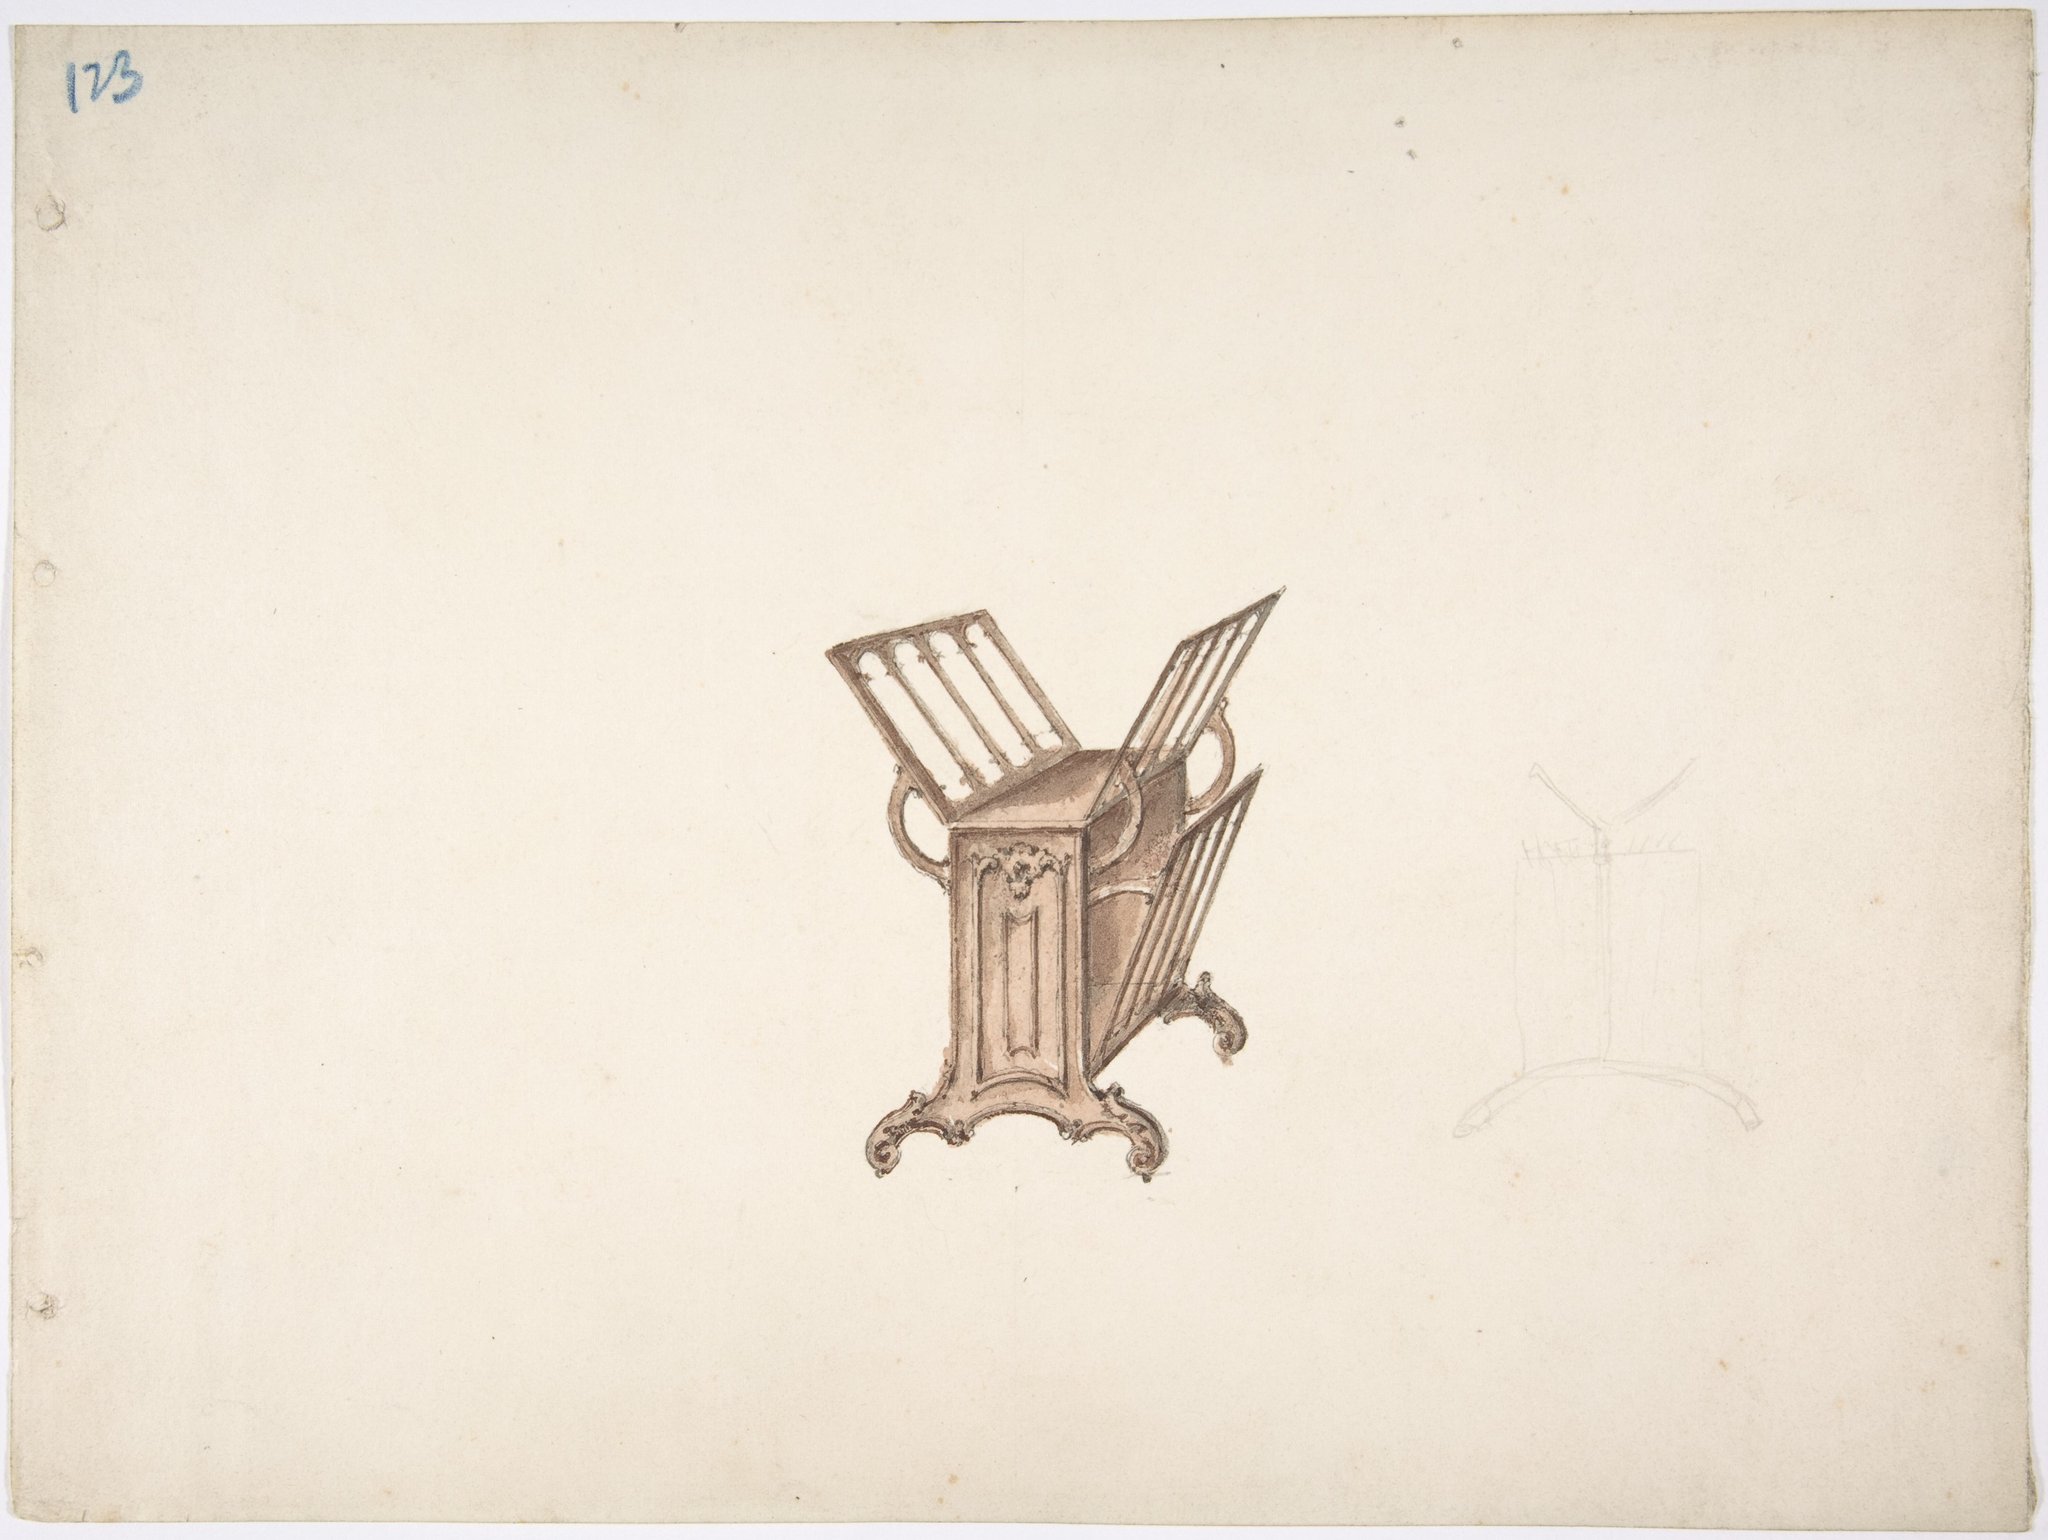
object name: drawing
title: Design for a Bookstand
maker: anonymous, british, 19th century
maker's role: artist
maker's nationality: british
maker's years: 1800-1900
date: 1801-1833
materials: ink, watercolor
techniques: pen